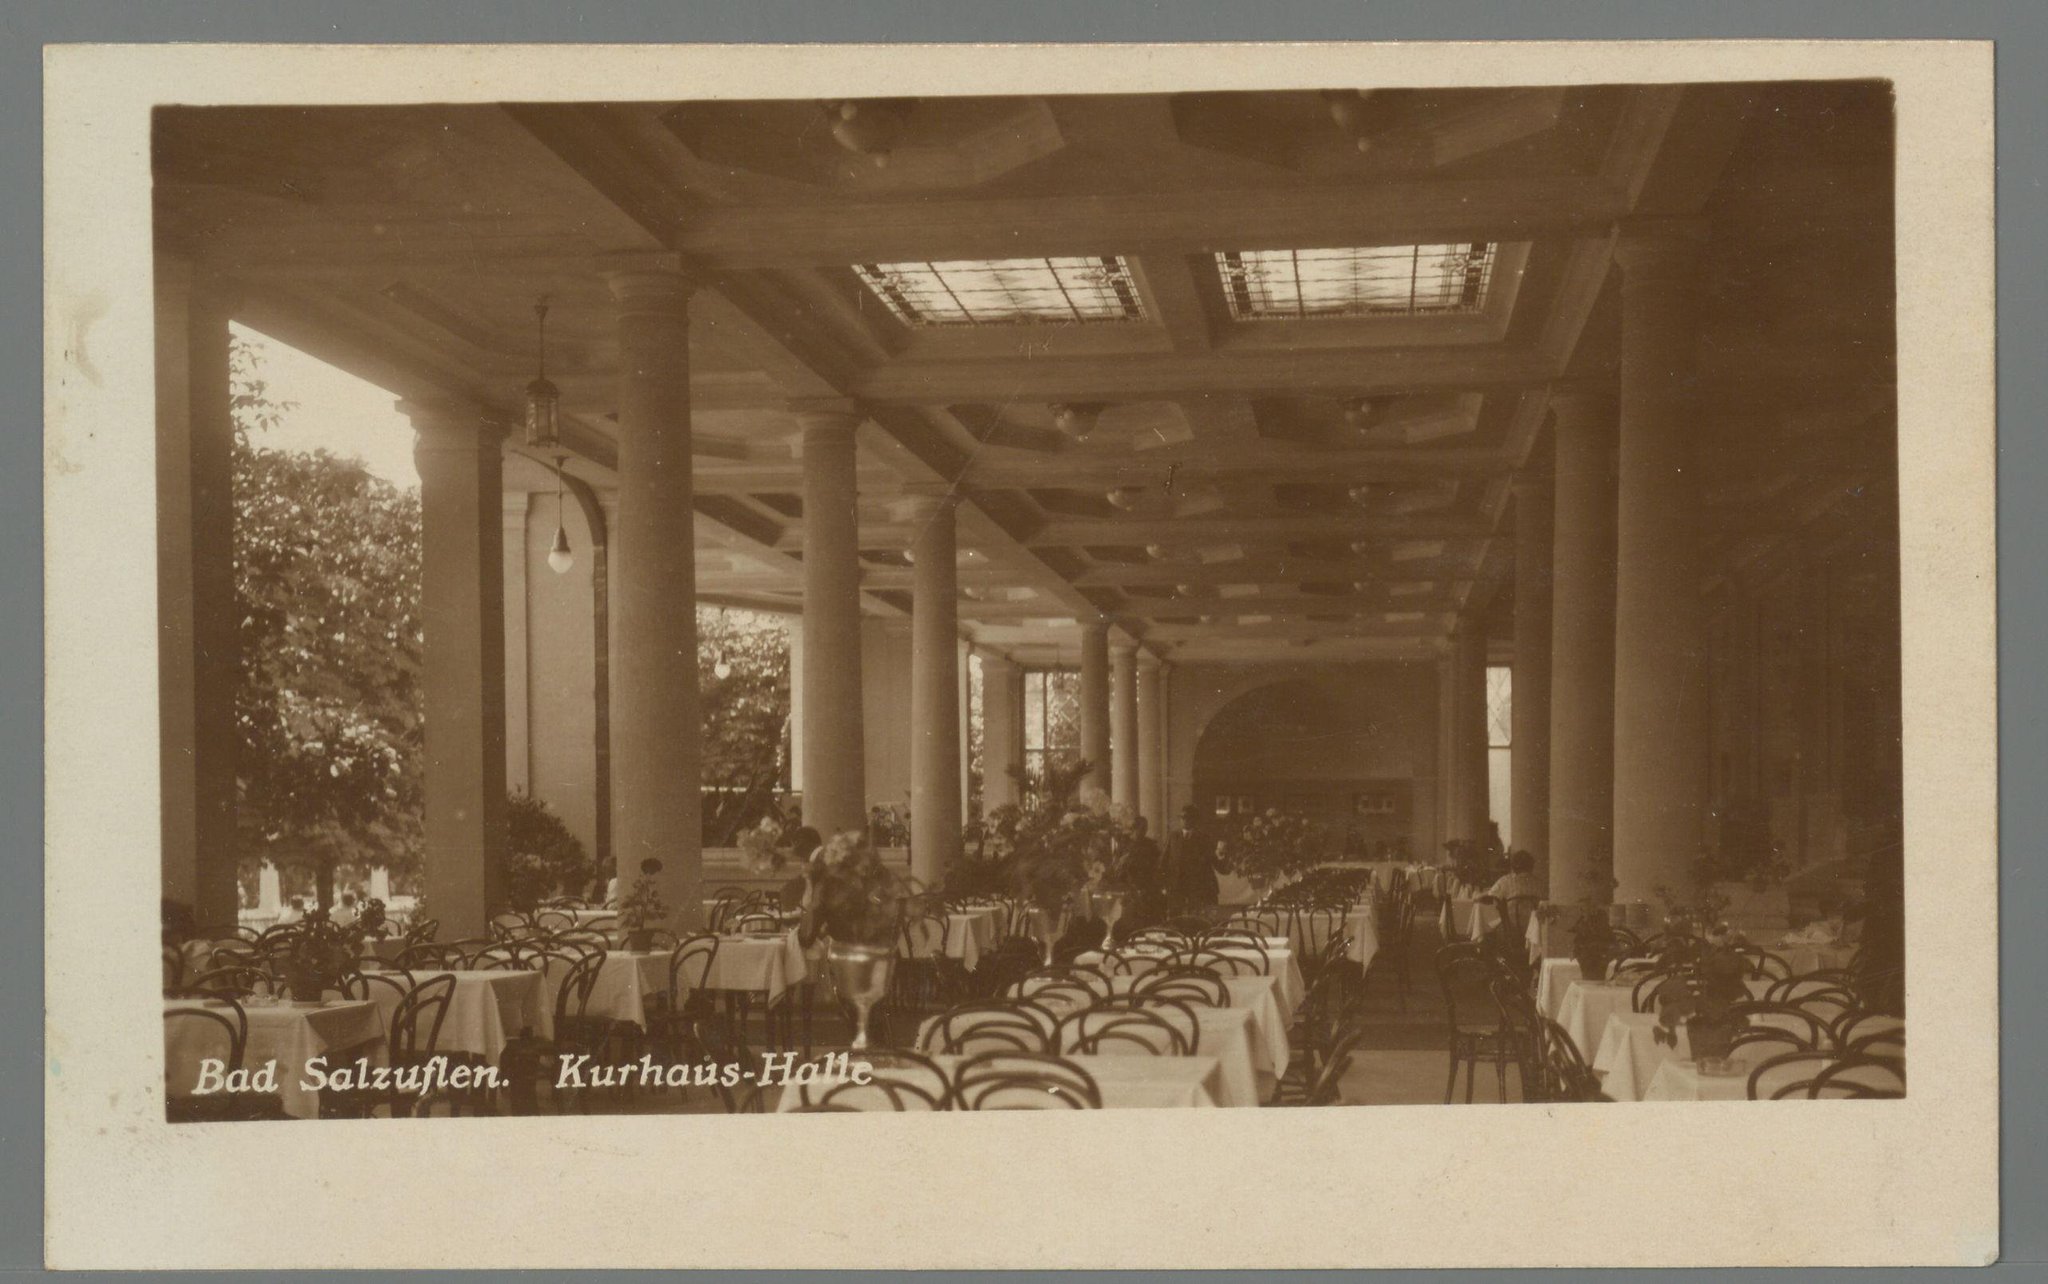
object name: ansichtkaart, prentbriefkaart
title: Bad-Salzuflen. Kurhaus-Halle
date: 1905-1930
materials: photographic support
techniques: gelatin silver print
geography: dortmund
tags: watering-place, spa, restaurant